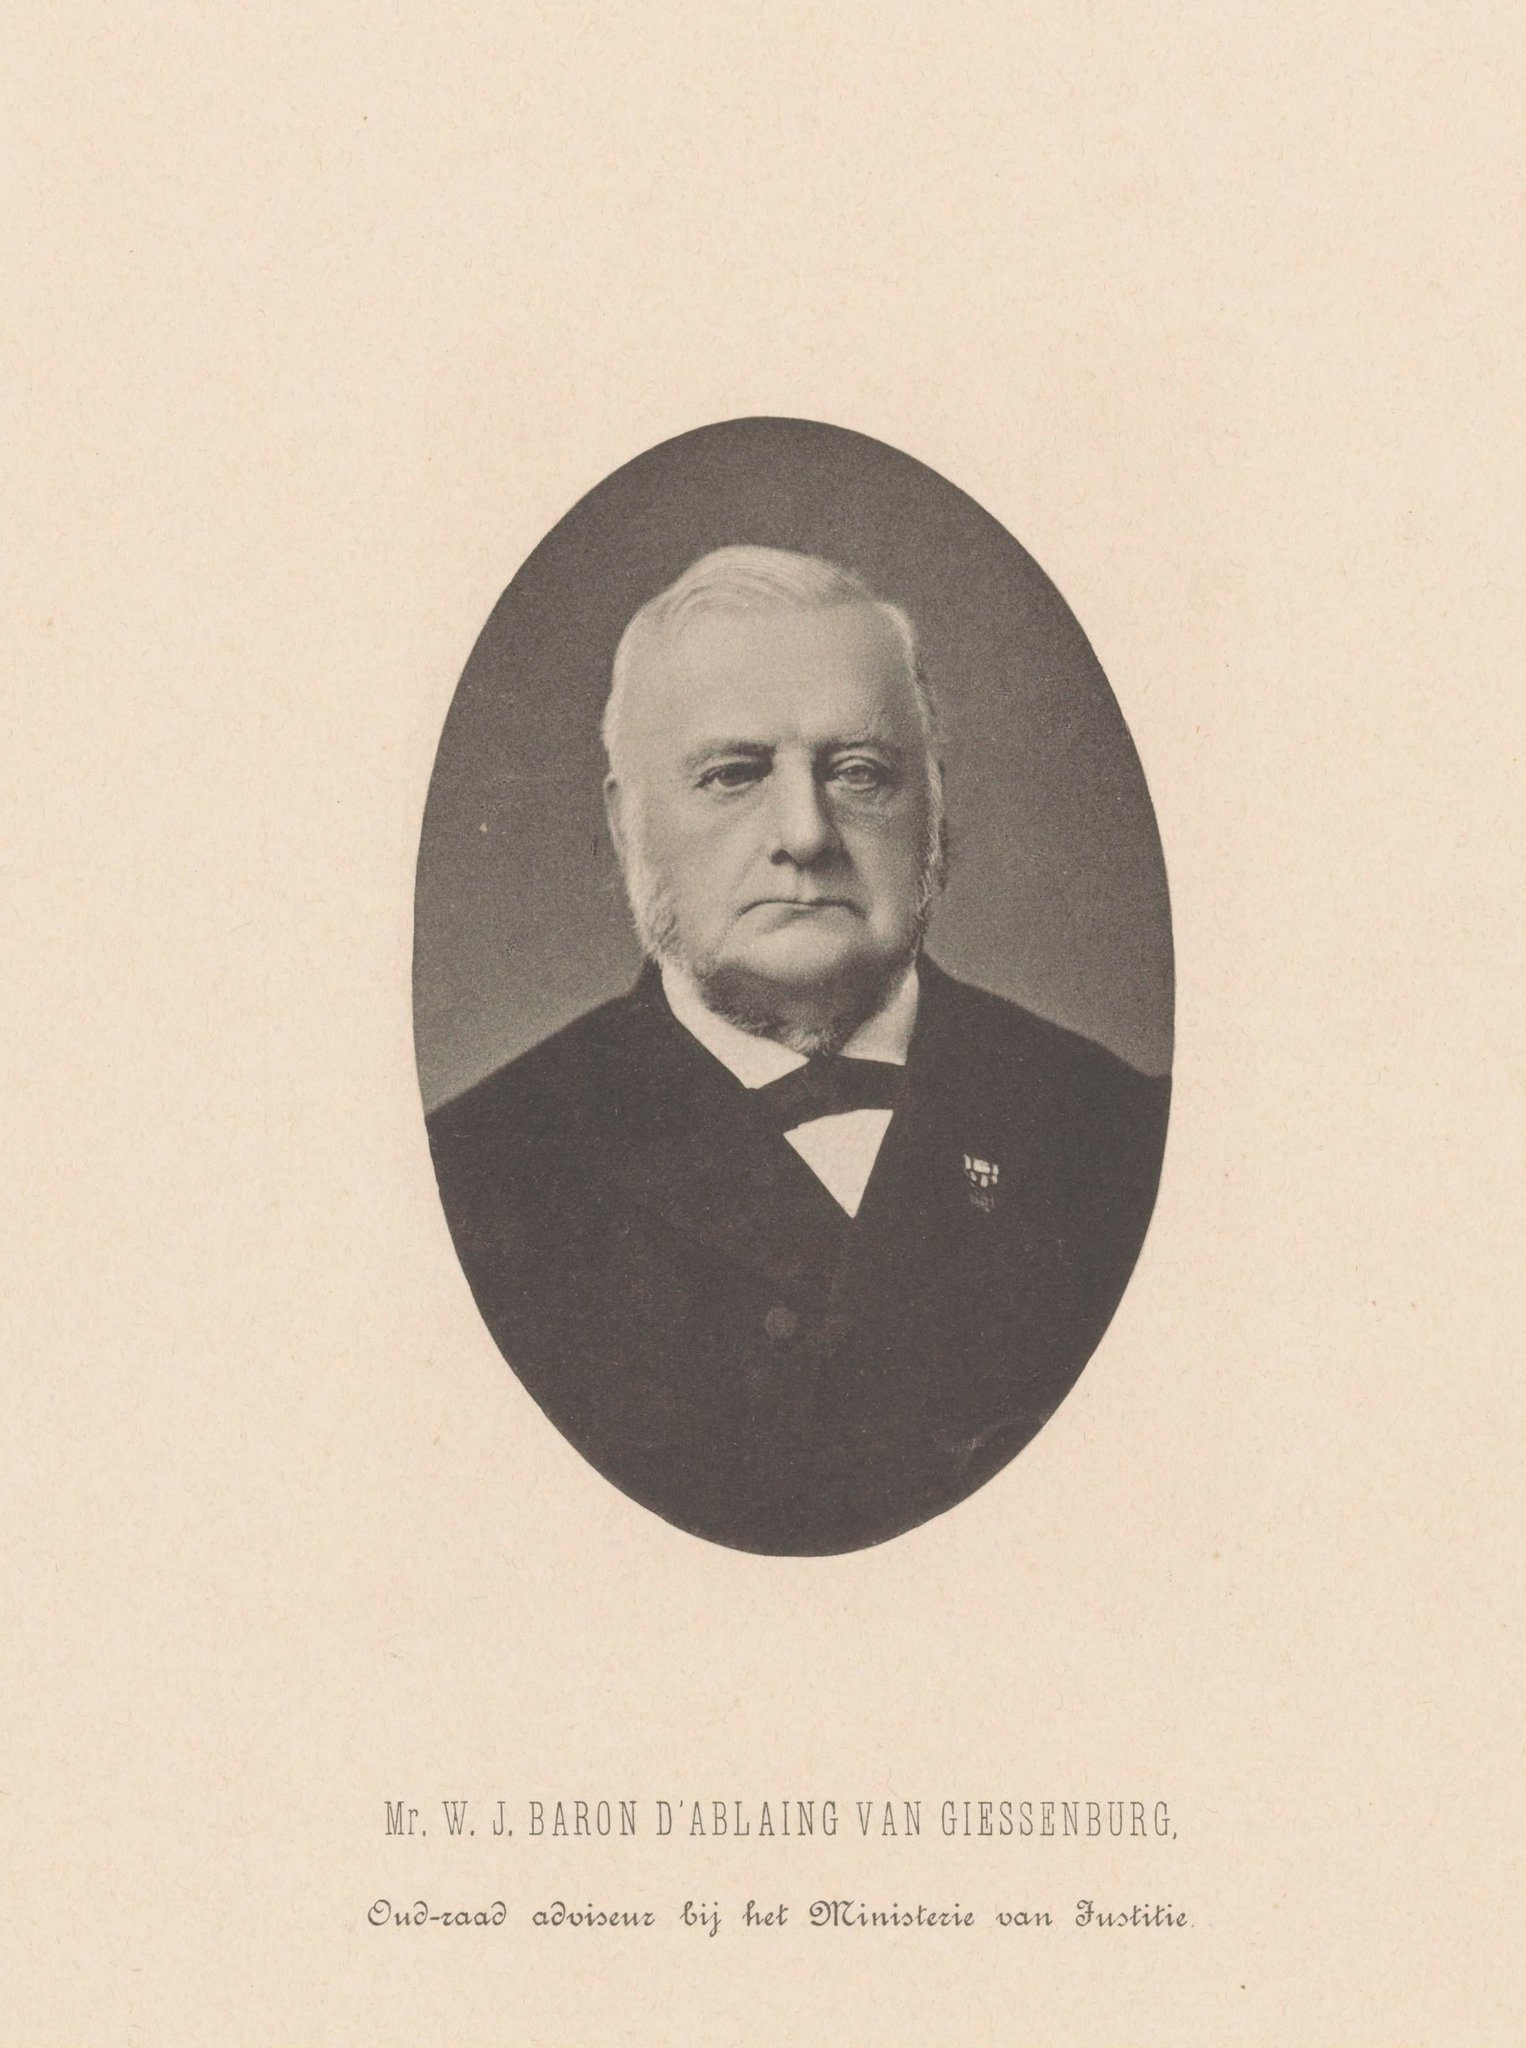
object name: photomechanical print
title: Portret van Willem Jan d'Ablaing van Giessenburg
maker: Anonymous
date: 1860-1892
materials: paper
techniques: photograph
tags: the hague, official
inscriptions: collector's mark: Lugt 2228, inscription: ‘AA No: 14’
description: Portret van Willem Jan d'Ablaing van Giessenburg in een ovale omlijsting. In de ondermarge zijn naam, zijn titel en zijn beroep.